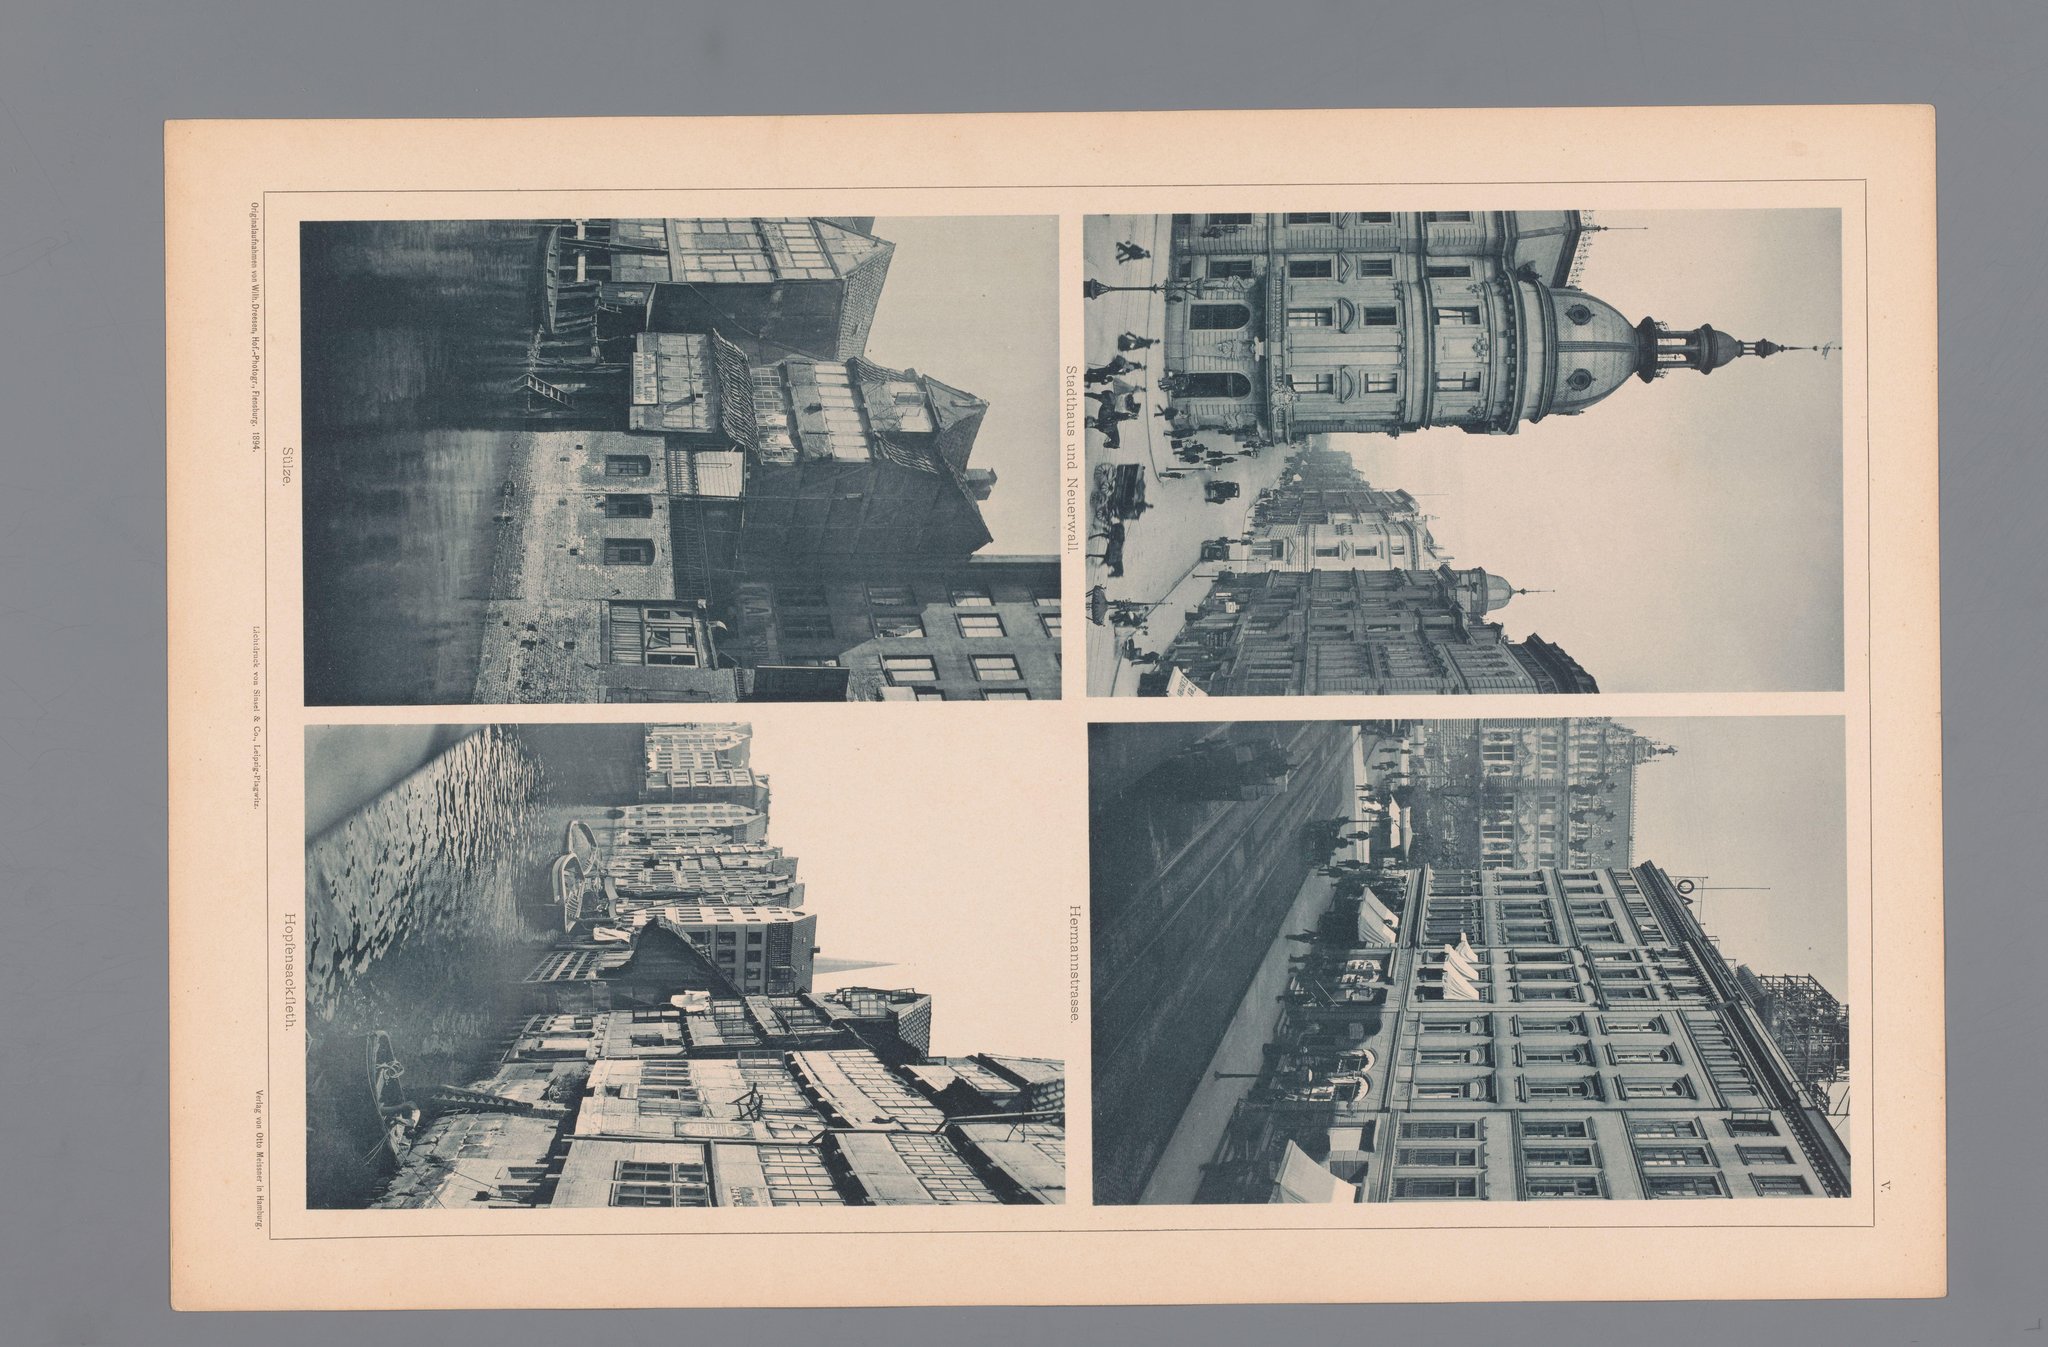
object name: photomechanical print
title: Stadthaus und Neuerwall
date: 1894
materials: paper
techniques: photograph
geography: hamburg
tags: townhall, street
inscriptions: inscription: ‘Originalaufnahmen von Wilh. Dreesen, Hof.-Photogr., Flensburg. 1894.’, number: ‘V.’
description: Deze prenten maken deel uit van een omslag met 126 prenten op 37 bladen en een tekstblad.